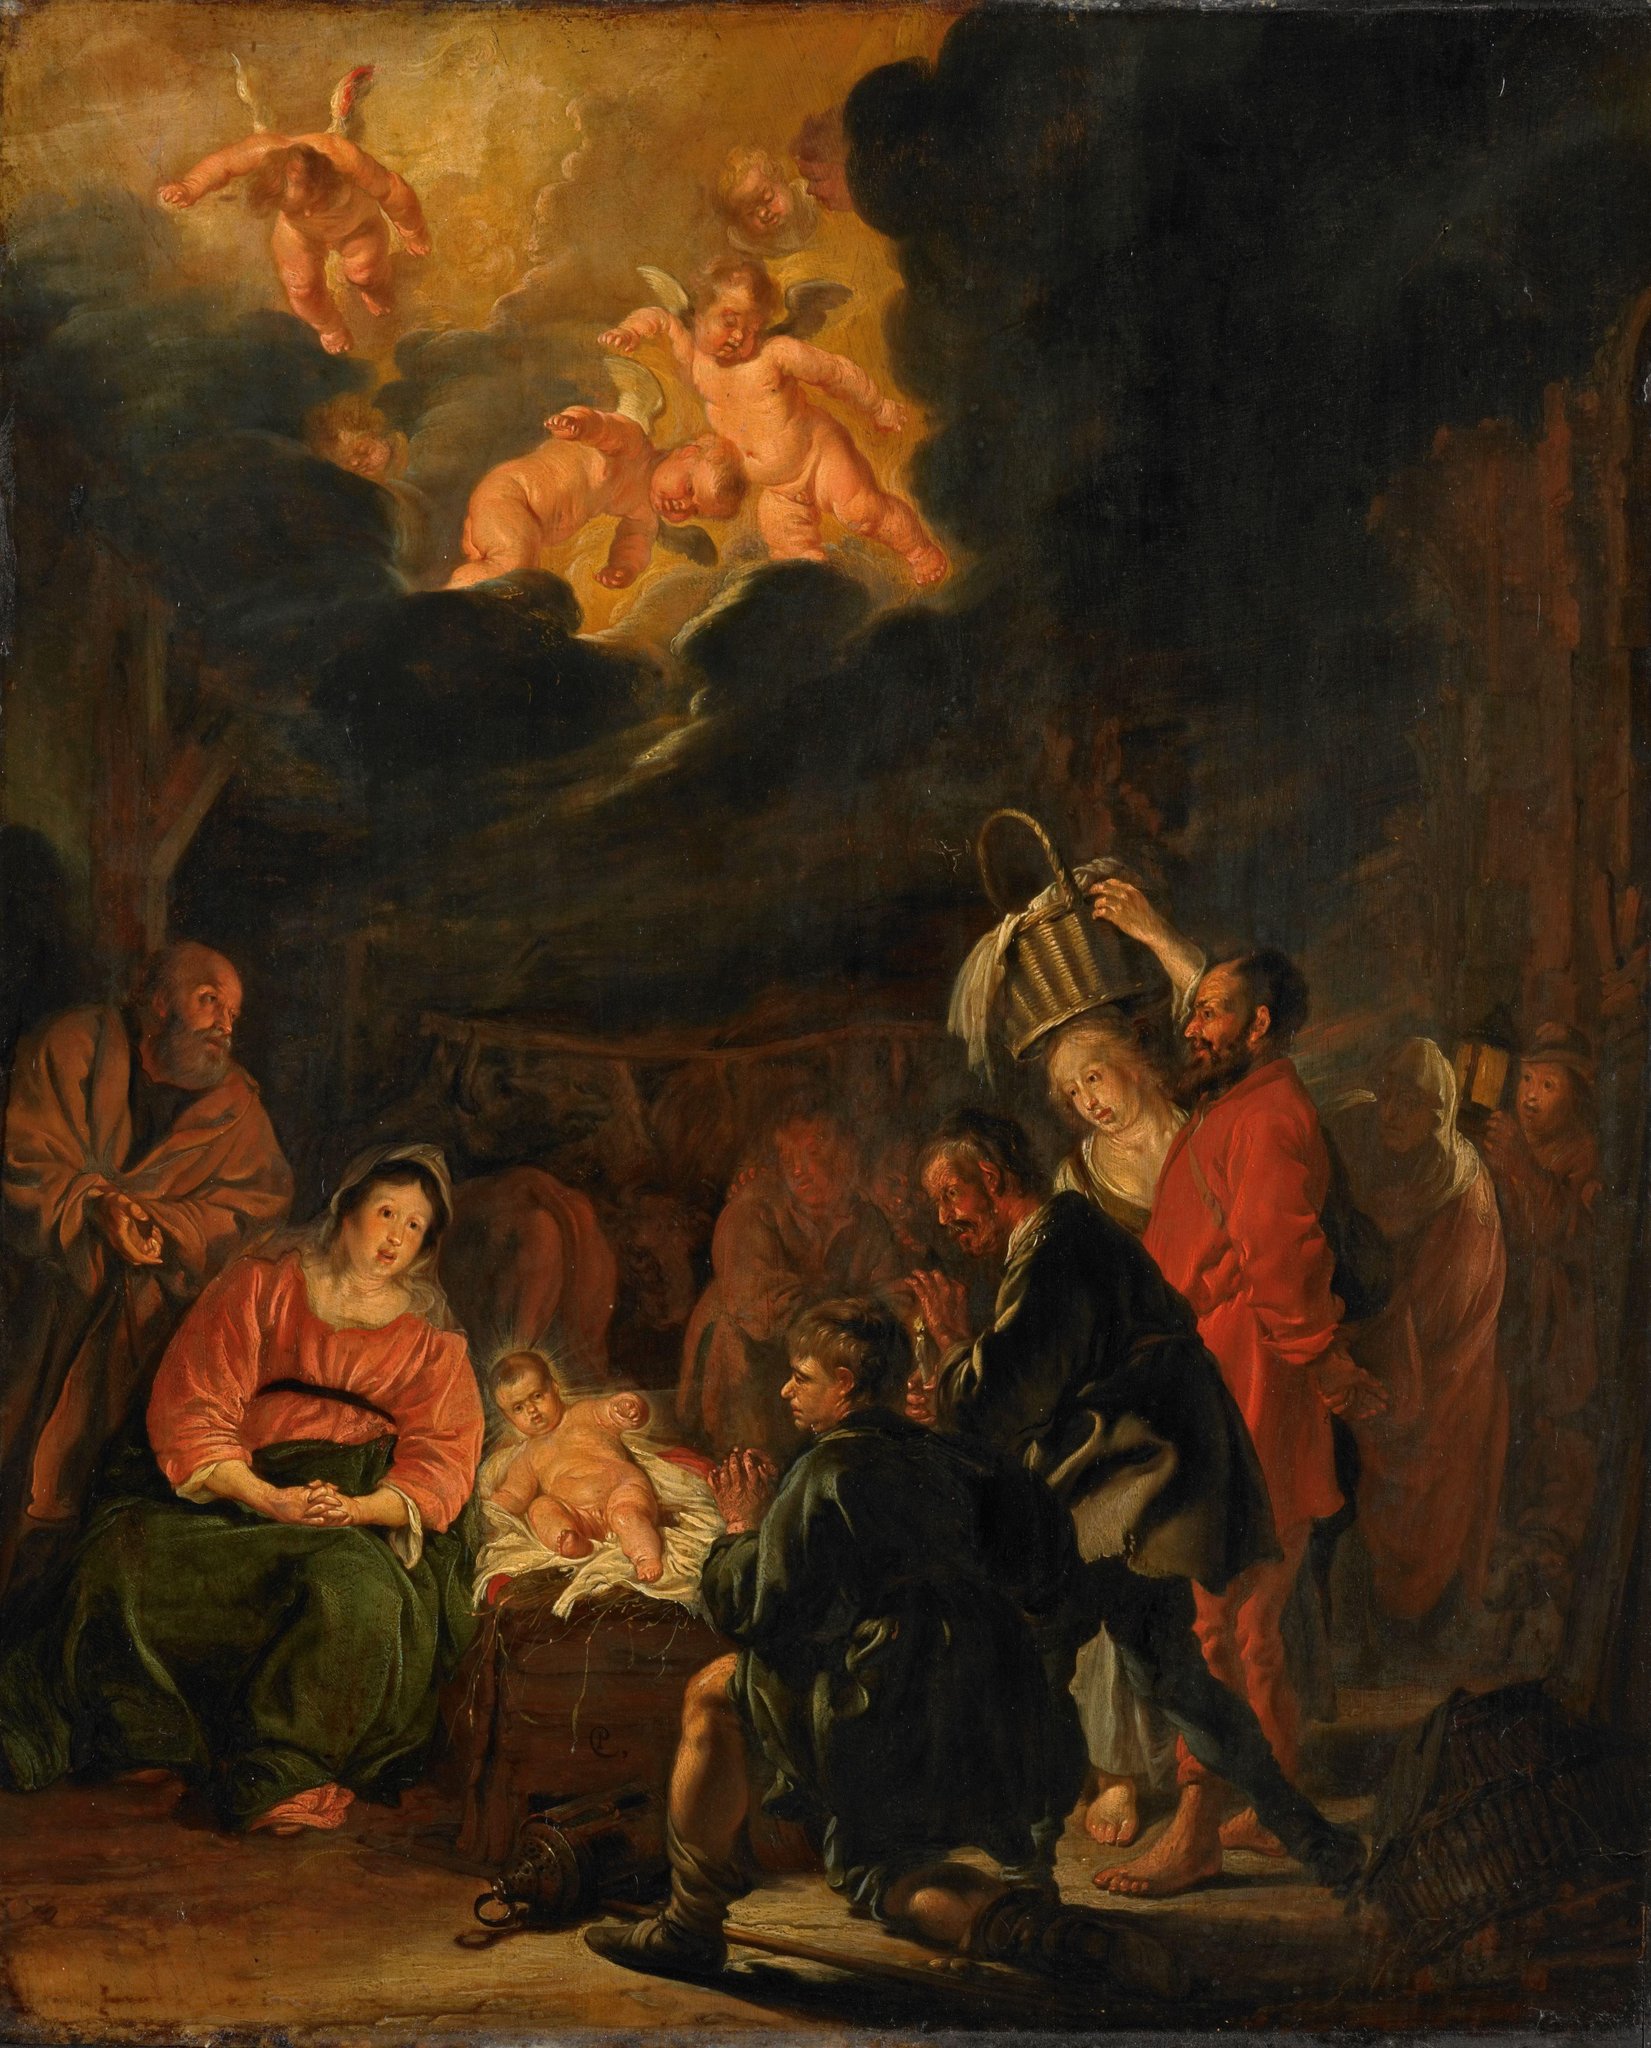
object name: painting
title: The Adoration of the Shepherds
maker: pieter codde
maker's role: painter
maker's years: 1599-1678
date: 1645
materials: oil, panel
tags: adoration of the christ-child by the shepherds; mary and joseph present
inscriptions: signature, in ligated monogram, on the cradle: ‘PC.’, date, bottom right: ‘1645’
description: De aanbidding der herders. Links de heilige familie, rechts de herders. Boven een aantal engelen.